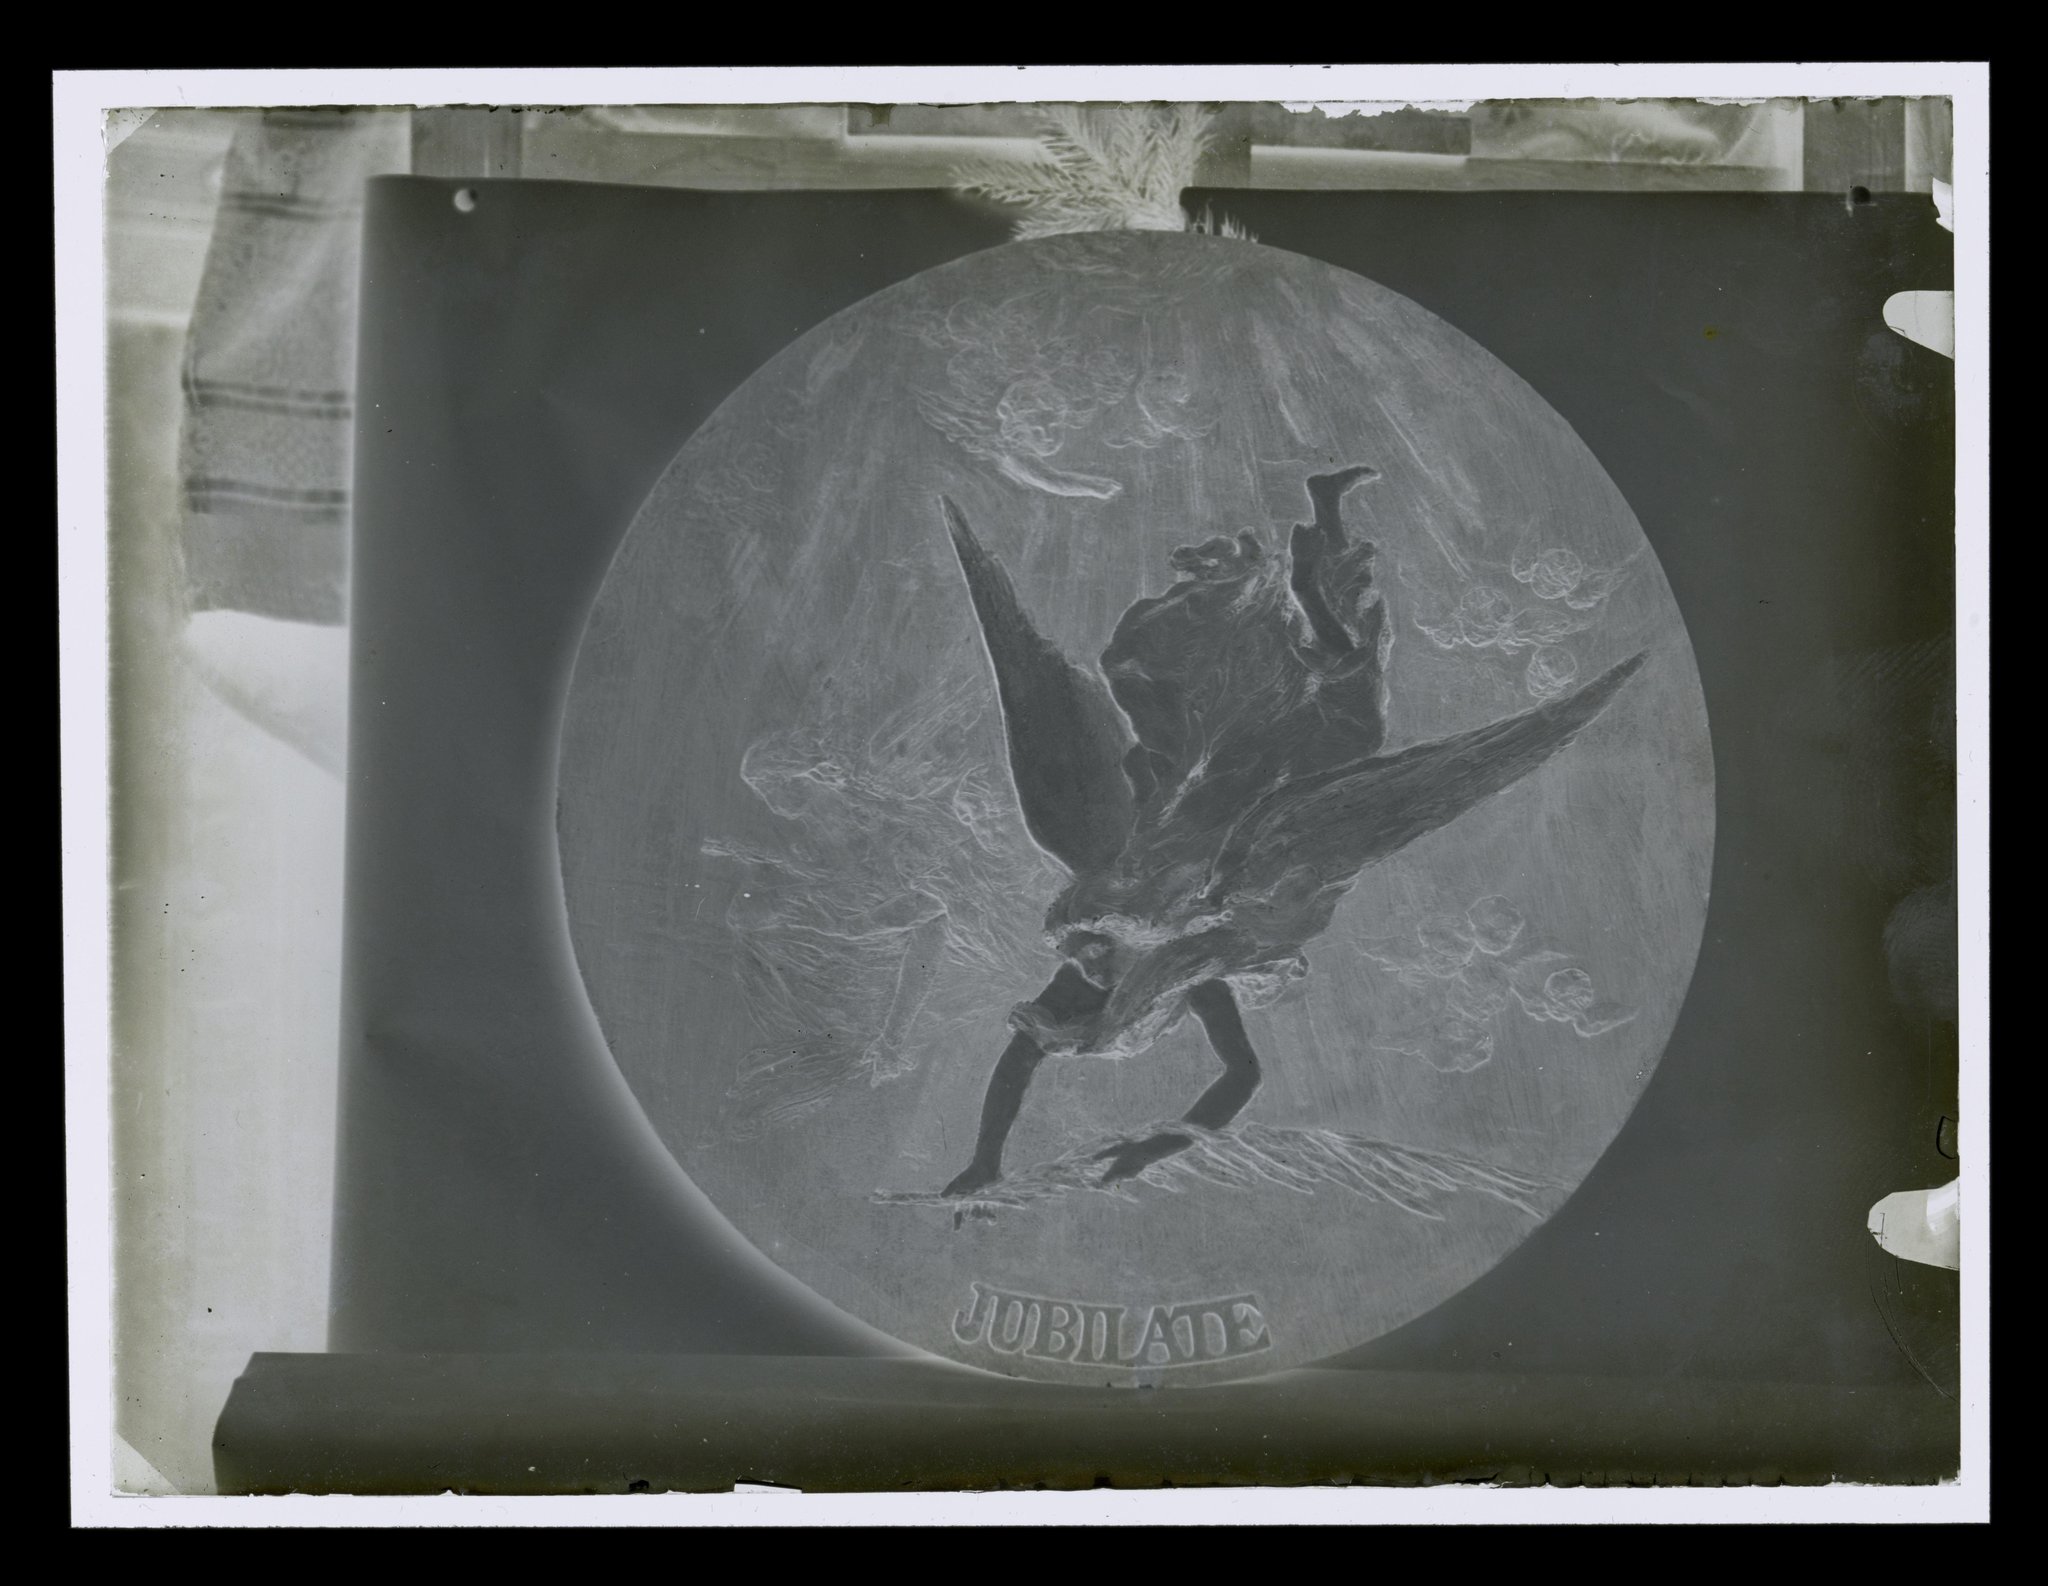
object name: glasnegatief, glasplaatnegatief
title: Plakkaat met reliëf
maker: laurens lodewijk kleijn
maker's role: draughtsman, painter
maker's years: 1826-1909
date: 1865-1900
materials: glass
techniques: collodion process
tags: art (+ relief ~ sculpture)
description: Onderdeel van groep glasnegatieven uit de nalatenschap van de schilder Laurens Lodewijk Kleijn, stillevens, portretten, zelfportretten en kunstreproducties.